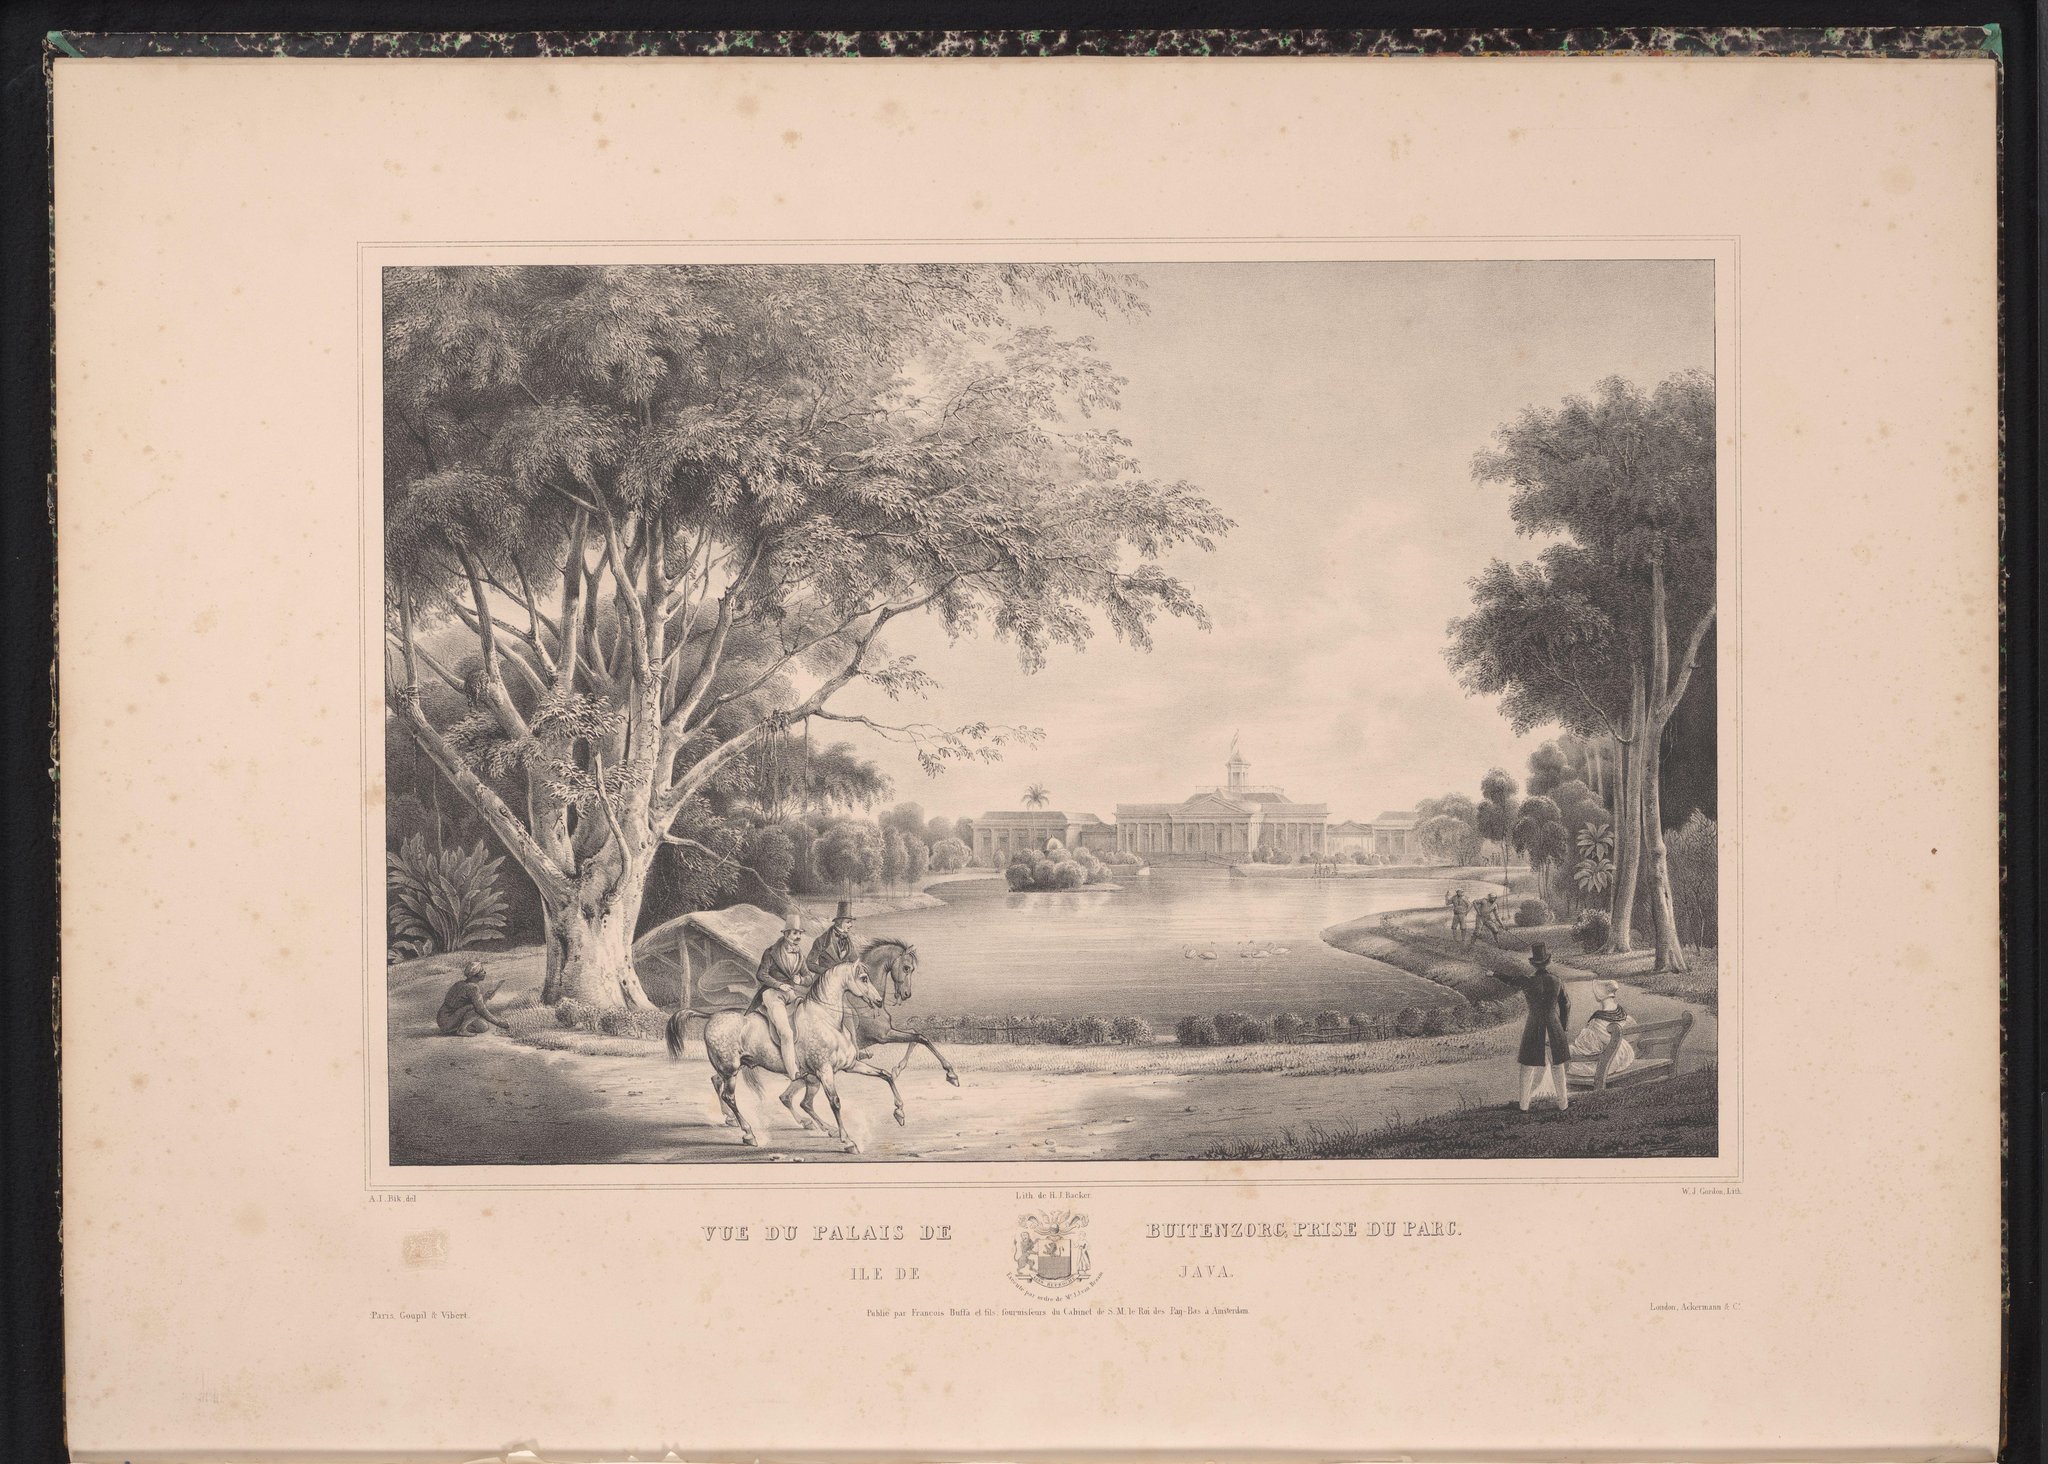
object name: album leaf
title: Vue du palais de Buitenzorg, prise du parc. Ile de Java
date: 1842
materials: paper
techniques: lithograph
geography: london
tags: rural housing, e.g. country-house, villa, cottage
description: Het paleis in de Plantentuin te Buitenzorg (West-Java) met op de voorgrond twee mannen te paard en recreërende mensen. Prent maakt deel uit van een album met een serie van zes lithografieën van gezichten te Java en een titelprent.